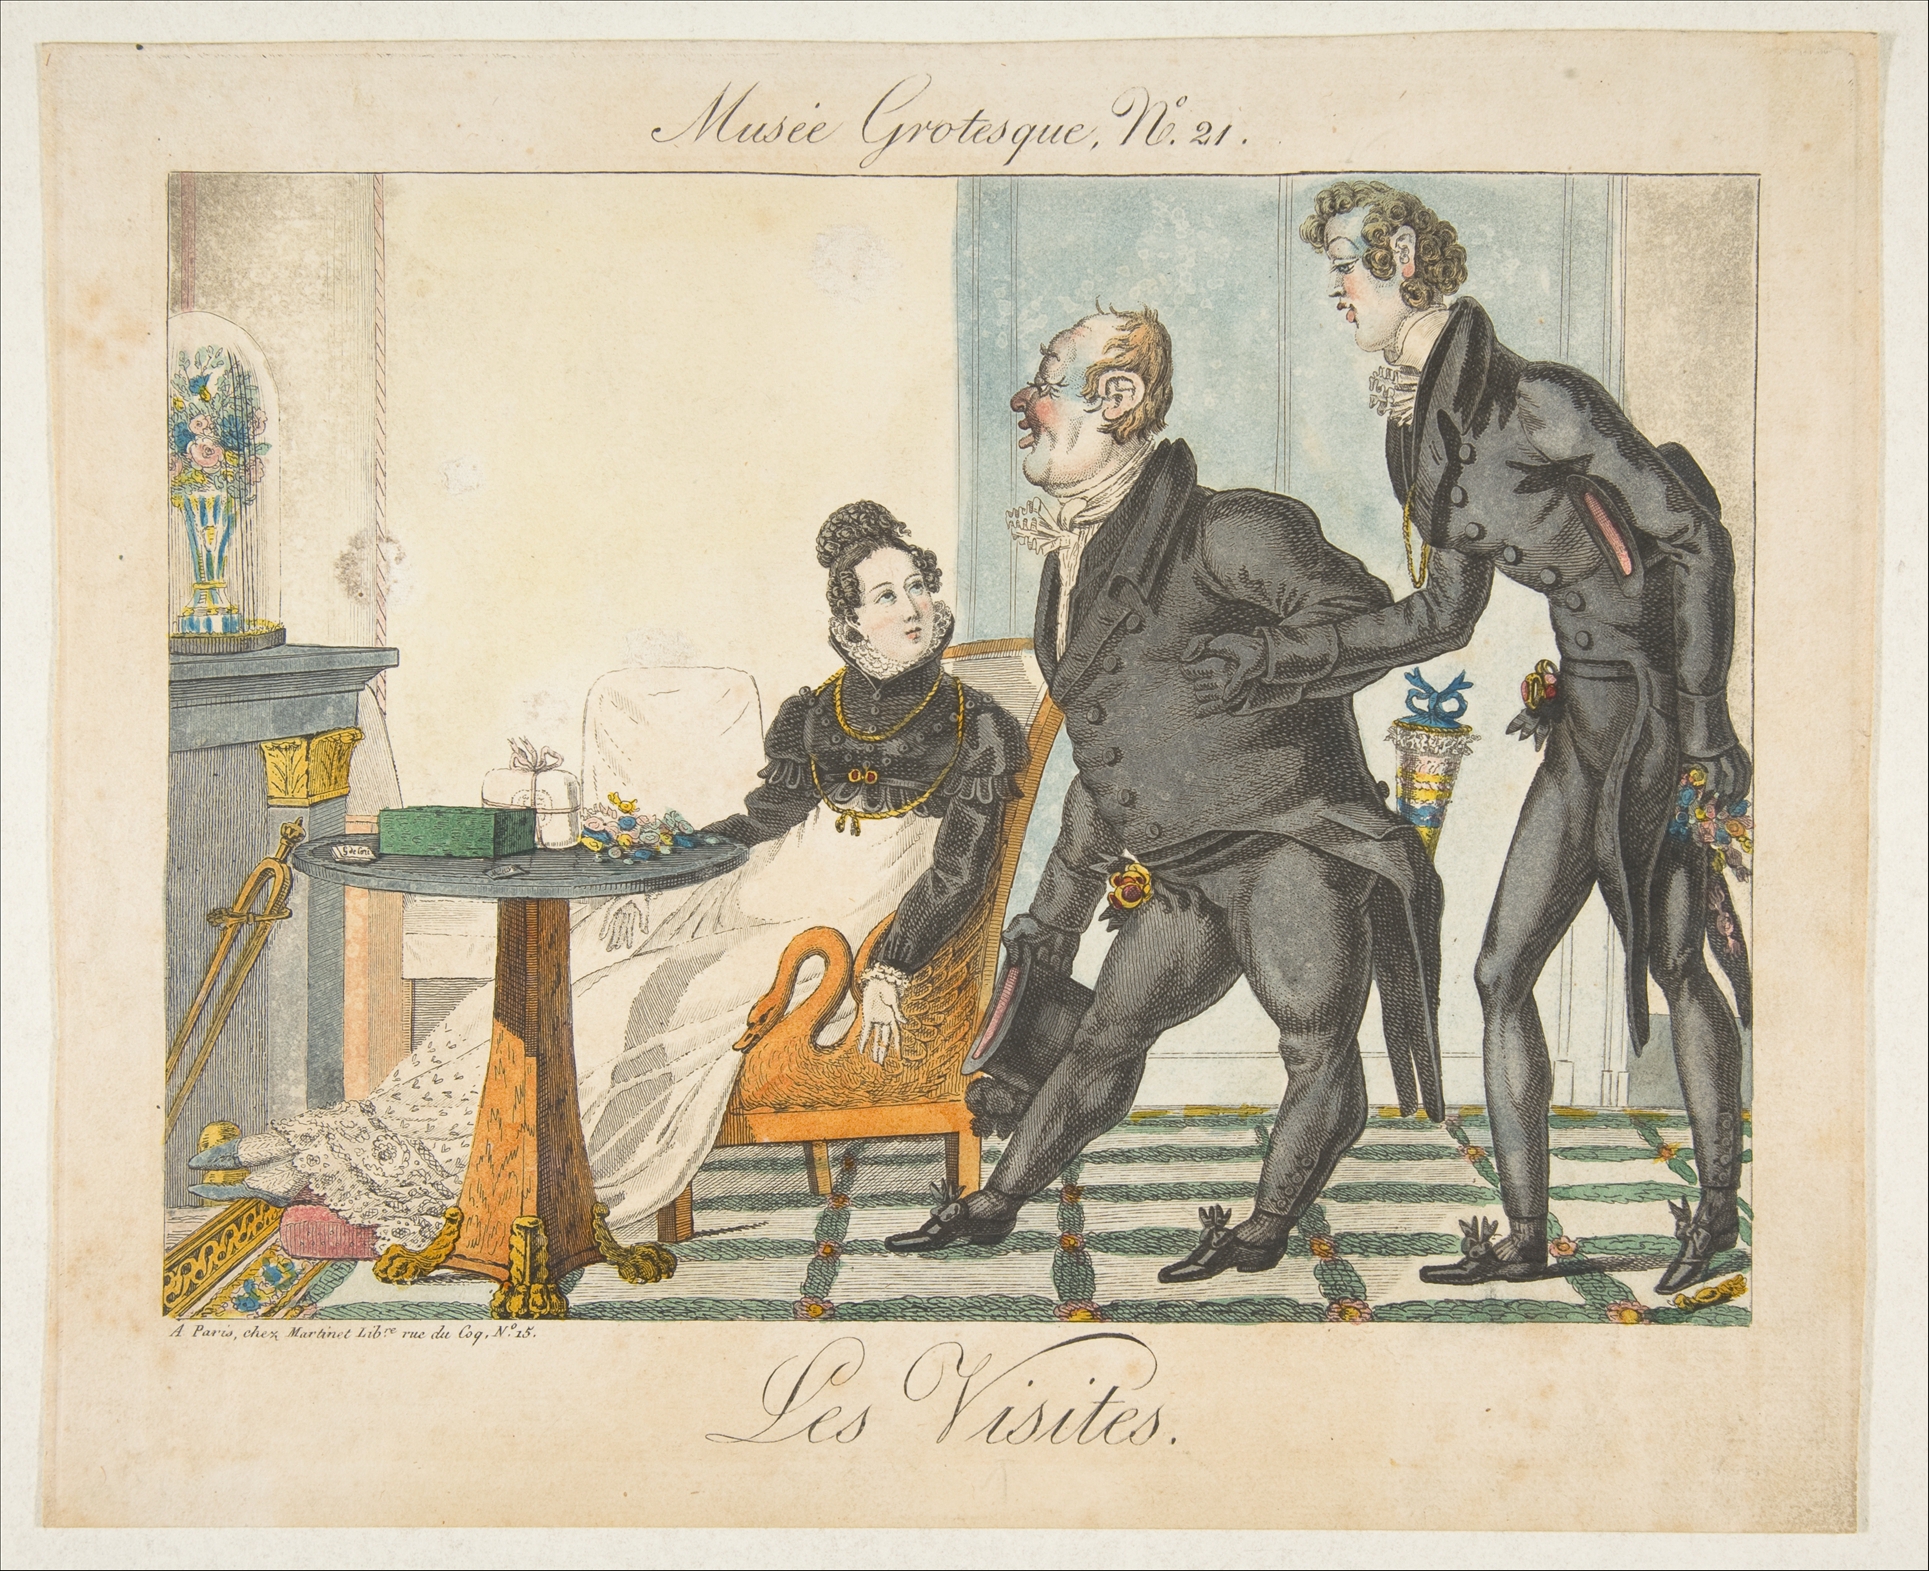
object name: print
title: Les Visites, Musée Grotesque, No. 21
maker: anonymous, french, 19th century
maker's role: artist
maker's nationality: french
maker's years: 1800-1900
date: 1801-1833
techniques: etching, hand coloring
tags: men,women